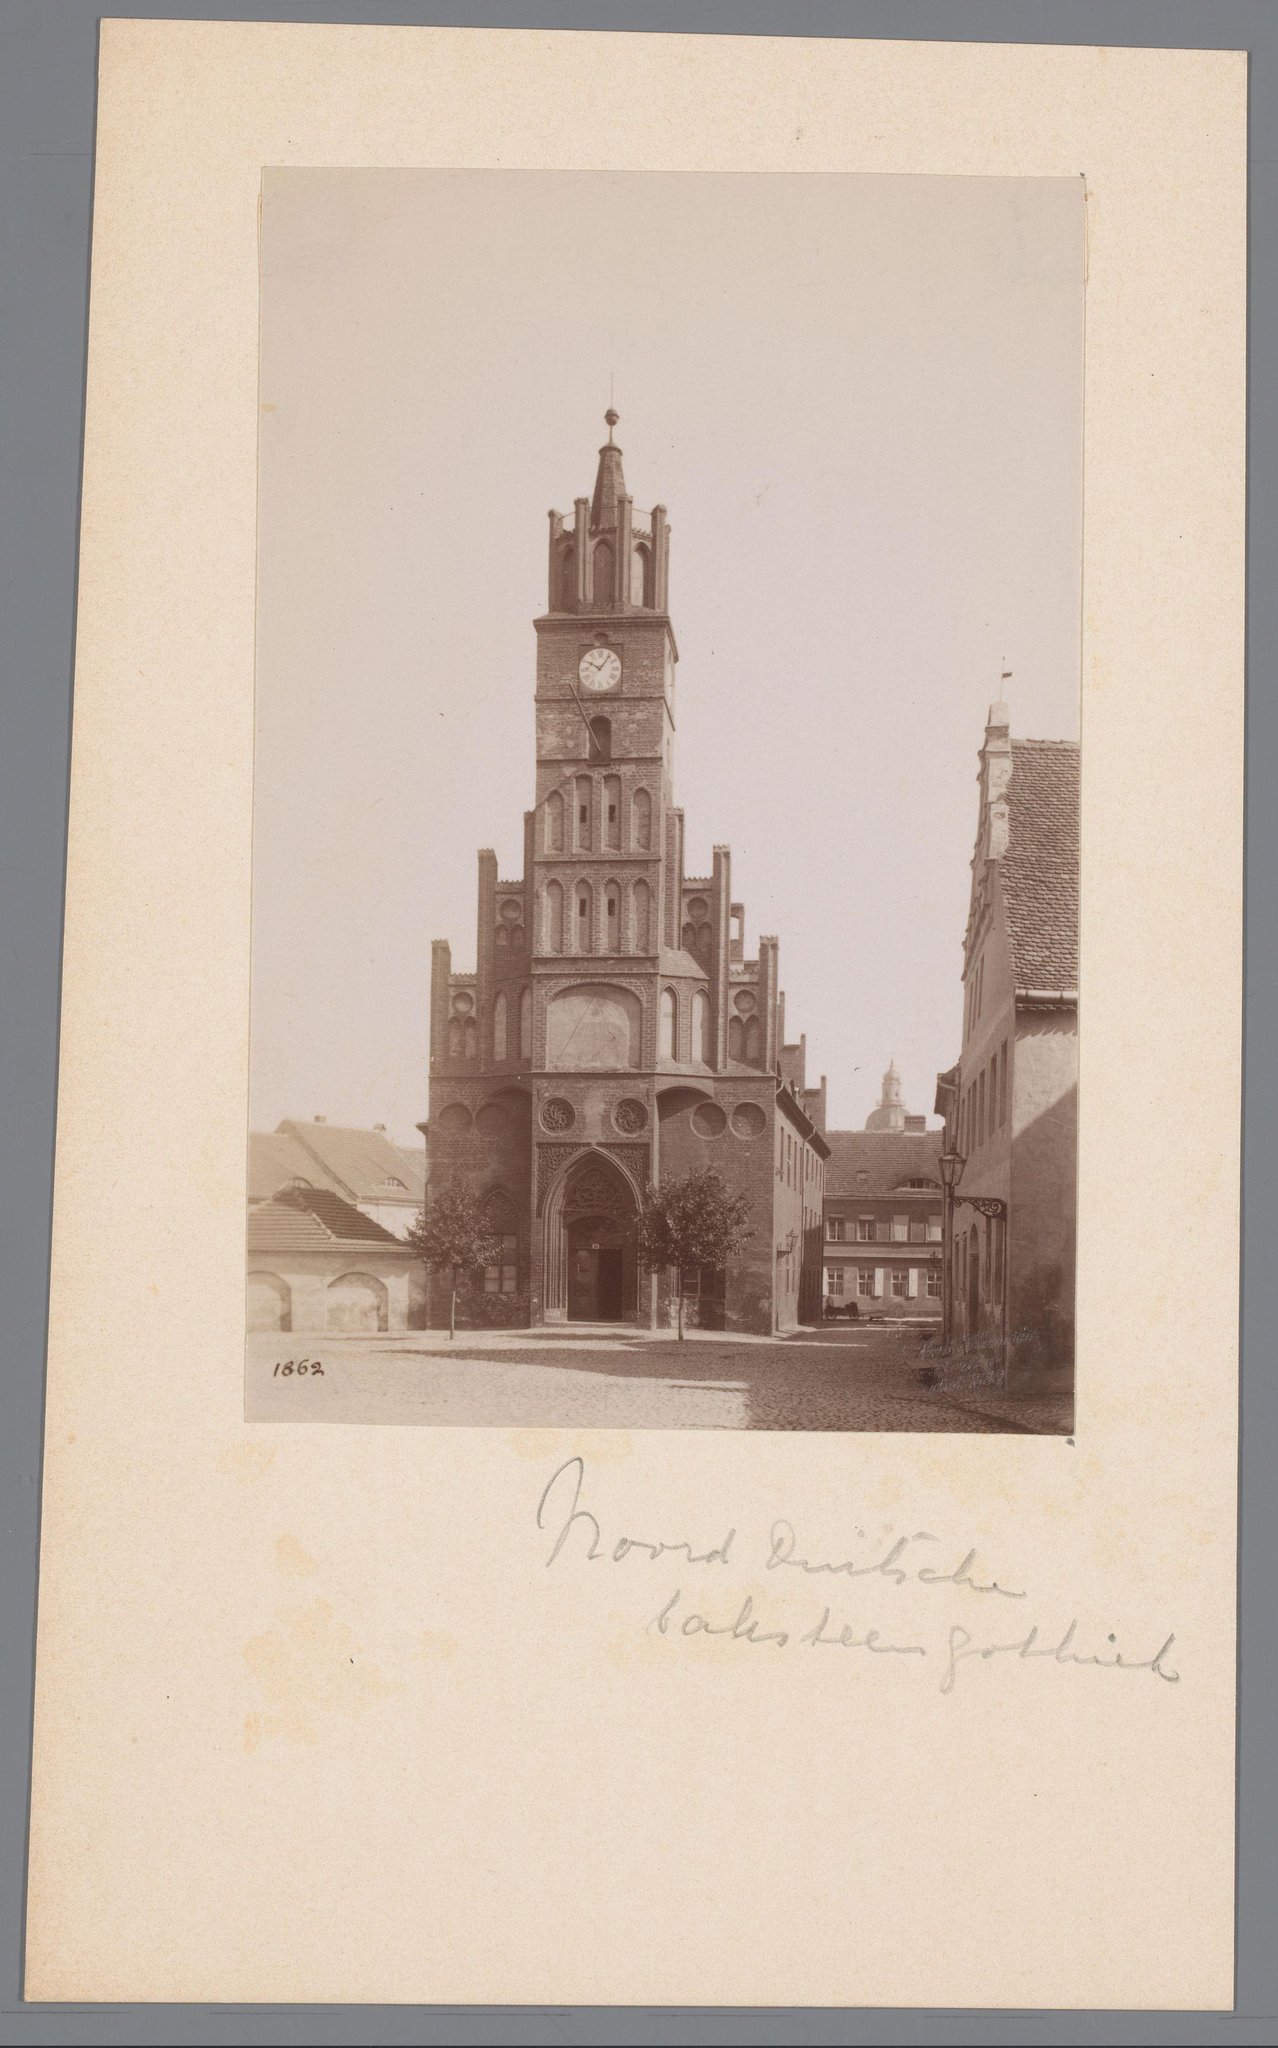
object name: photograph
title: Noord-Duitse kerk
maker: friedrich albert schwartz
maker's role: fotograaf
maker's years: 1836-1906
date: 1889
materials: paper, cardboard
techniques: collodion silver print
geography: germany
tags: church (exterior), germany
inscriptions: inscription: ‘Noord Duitsche baksteen gothiek’, number: ‘1862’